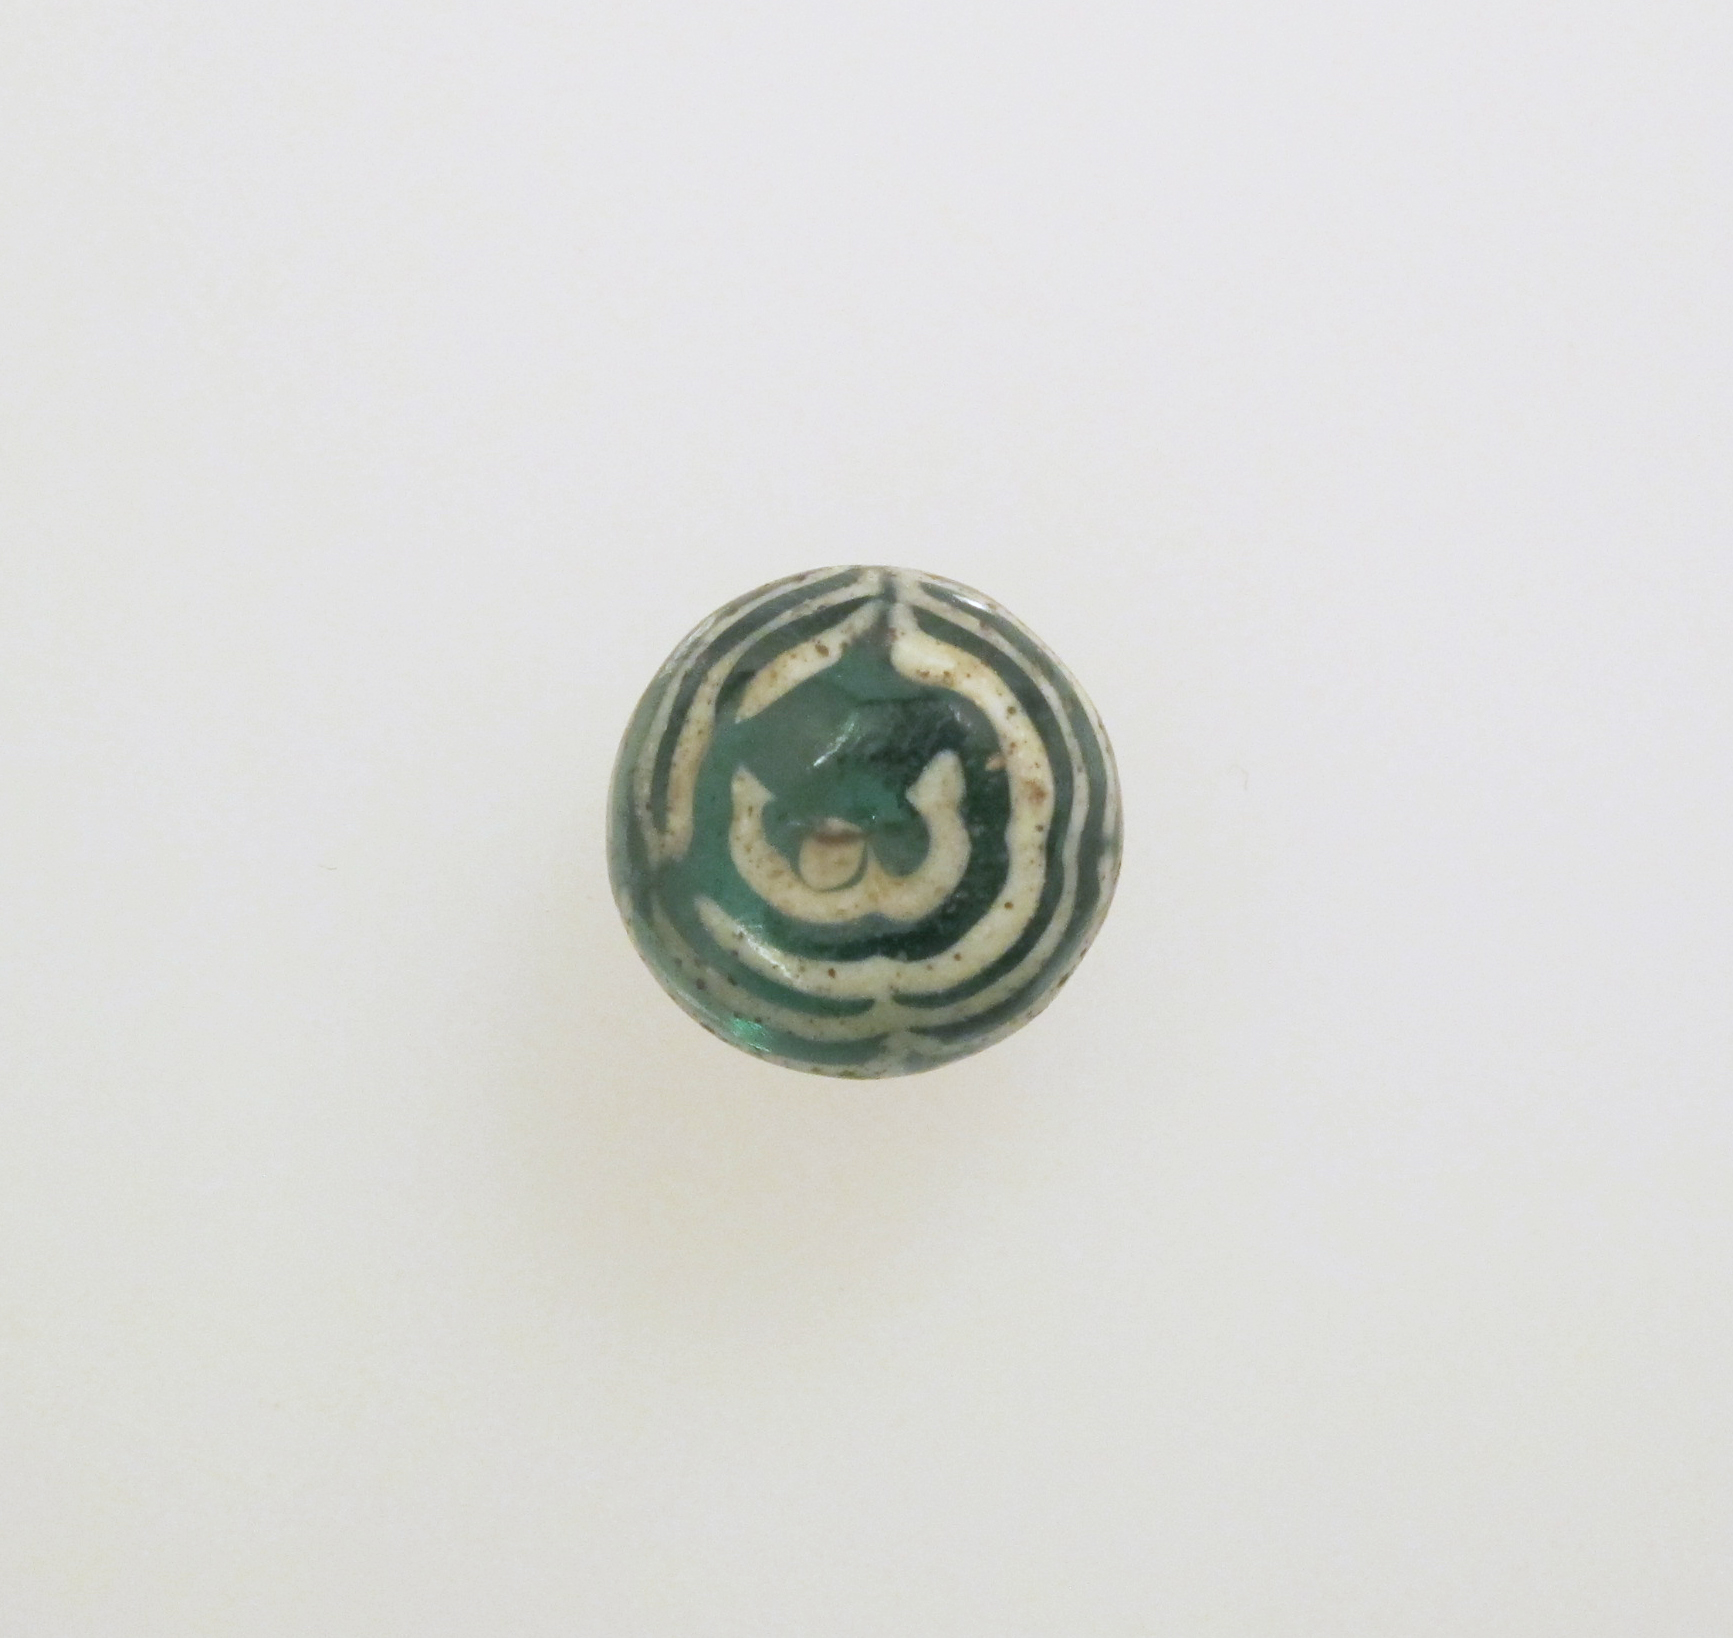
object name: pinhead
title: Glass pinhead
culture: roman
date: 31-330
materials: glass